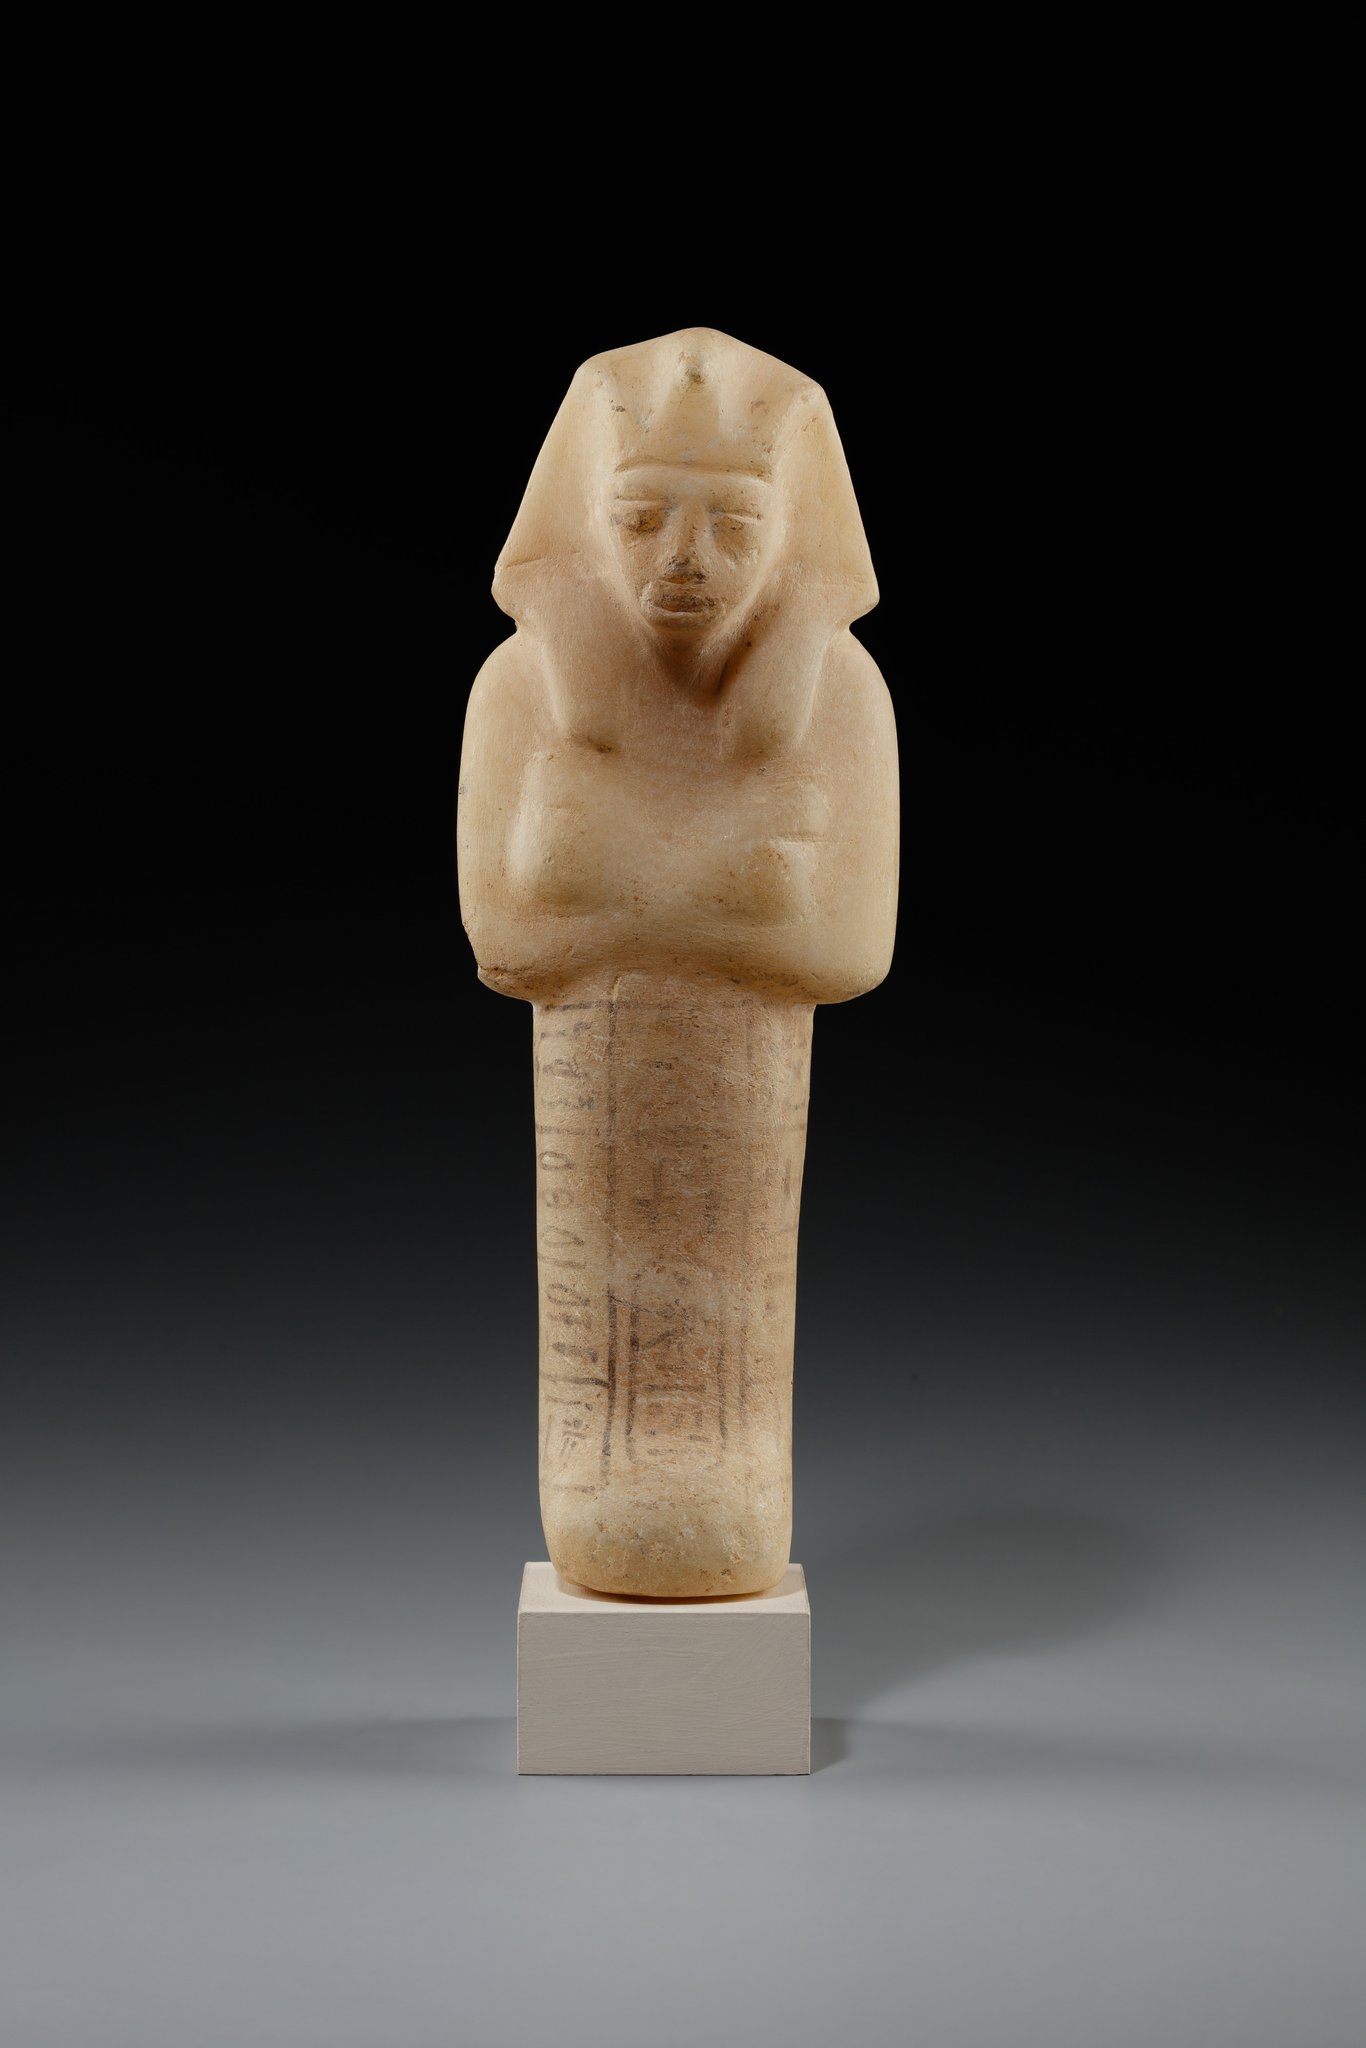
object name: shabti, siptah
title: Shabti of Siptah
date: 1194-1188 BCE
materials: stone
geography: egypt